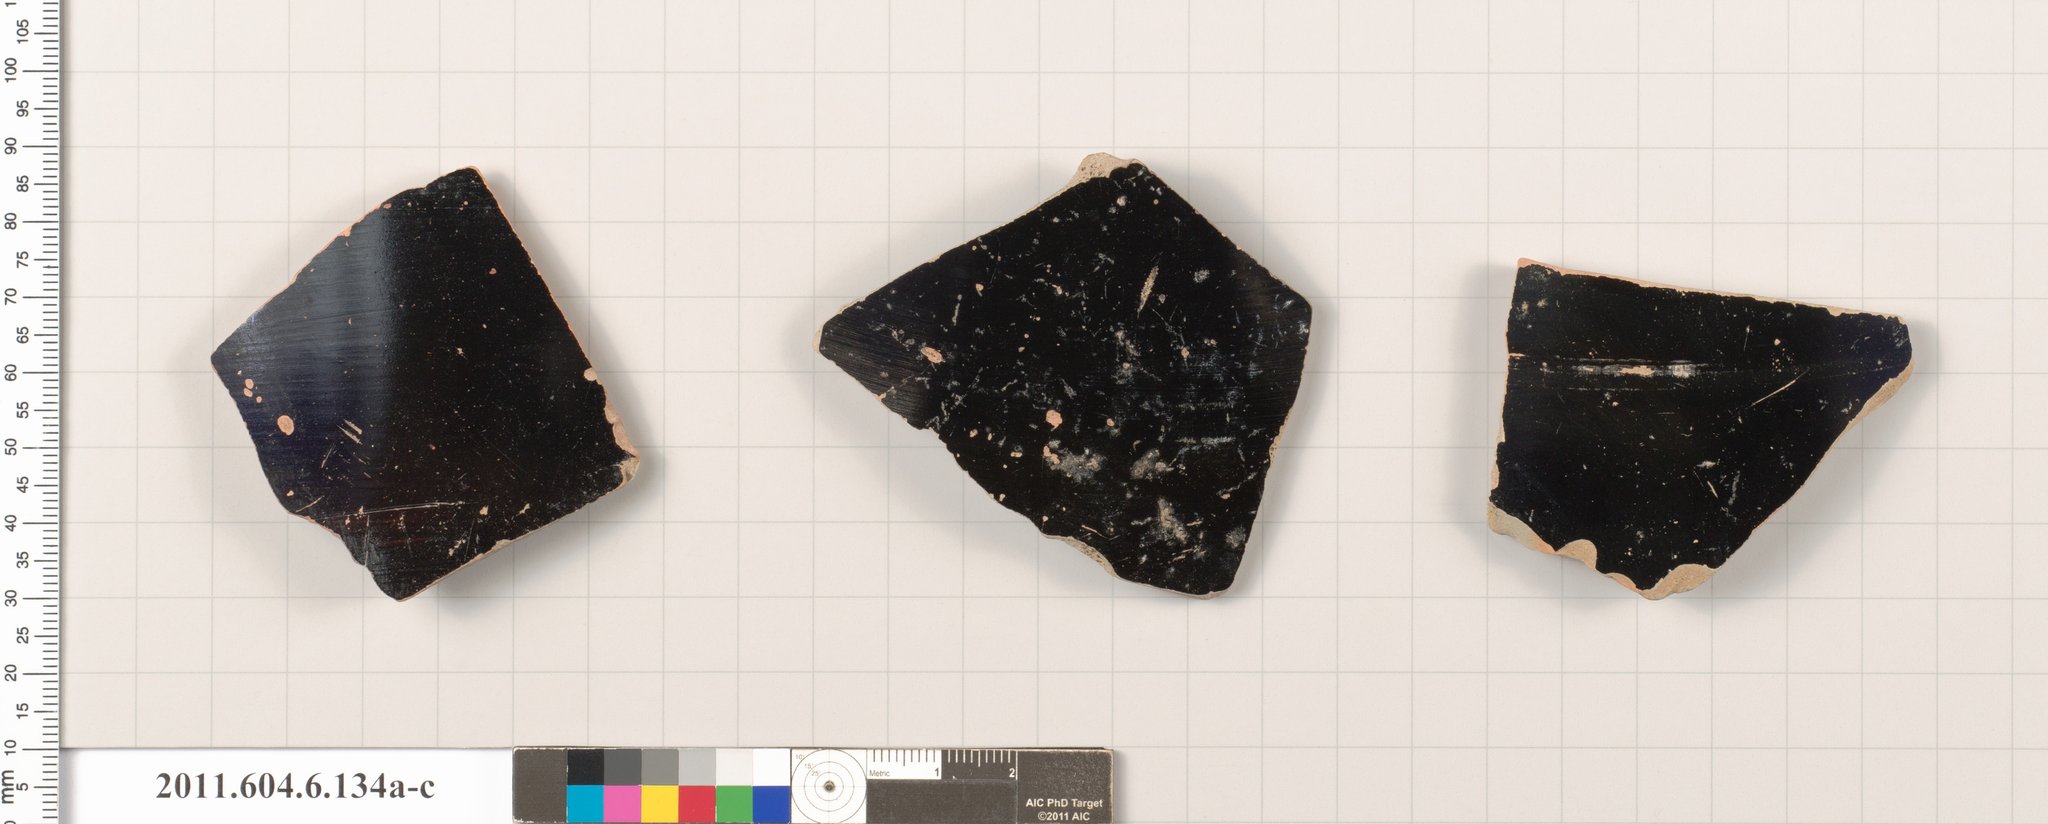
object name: undetermined open shape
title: Terracotta fragments of open shapes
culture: greek, attic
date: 600-401 BCE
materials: terracotta